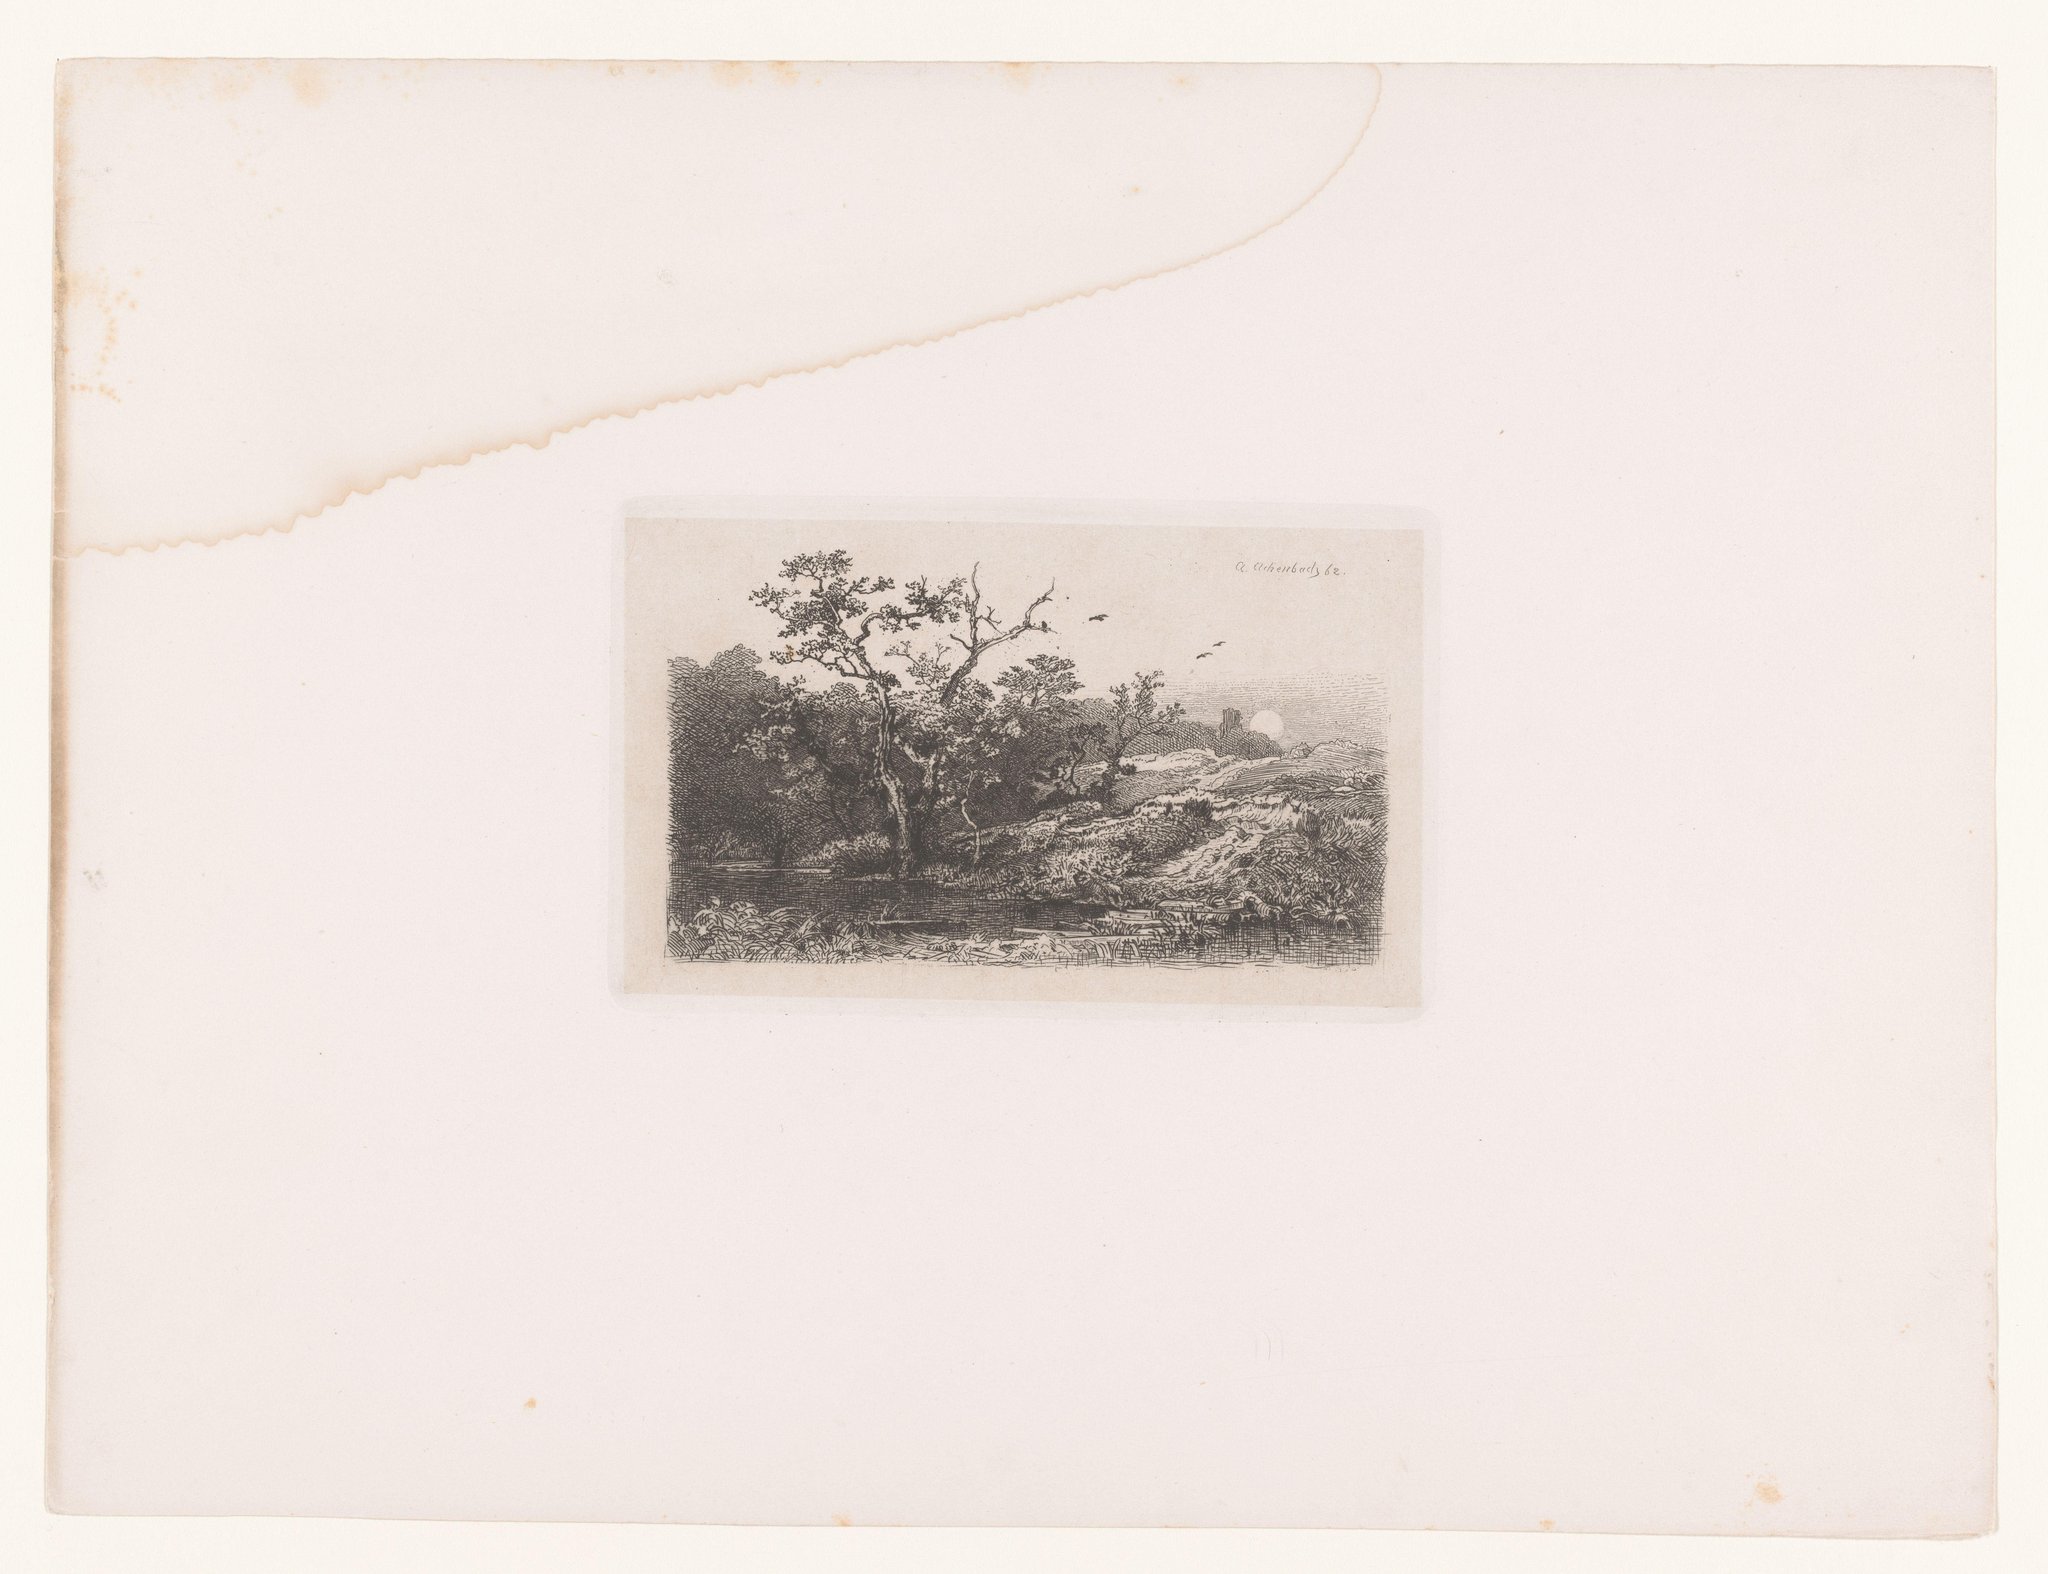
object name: print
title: Landschappen en zeegezichten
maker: andreas achenbach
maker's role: print maker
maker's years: 1815-1910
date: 1862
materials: paper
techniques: etching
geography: dusseldorf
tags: trees, landscapes, pond, pool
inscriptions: collector's mark: Lugt 2228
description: Deze prent maakt deel uit van een serie van twaalf prenten met landschappen en zeegezichten.